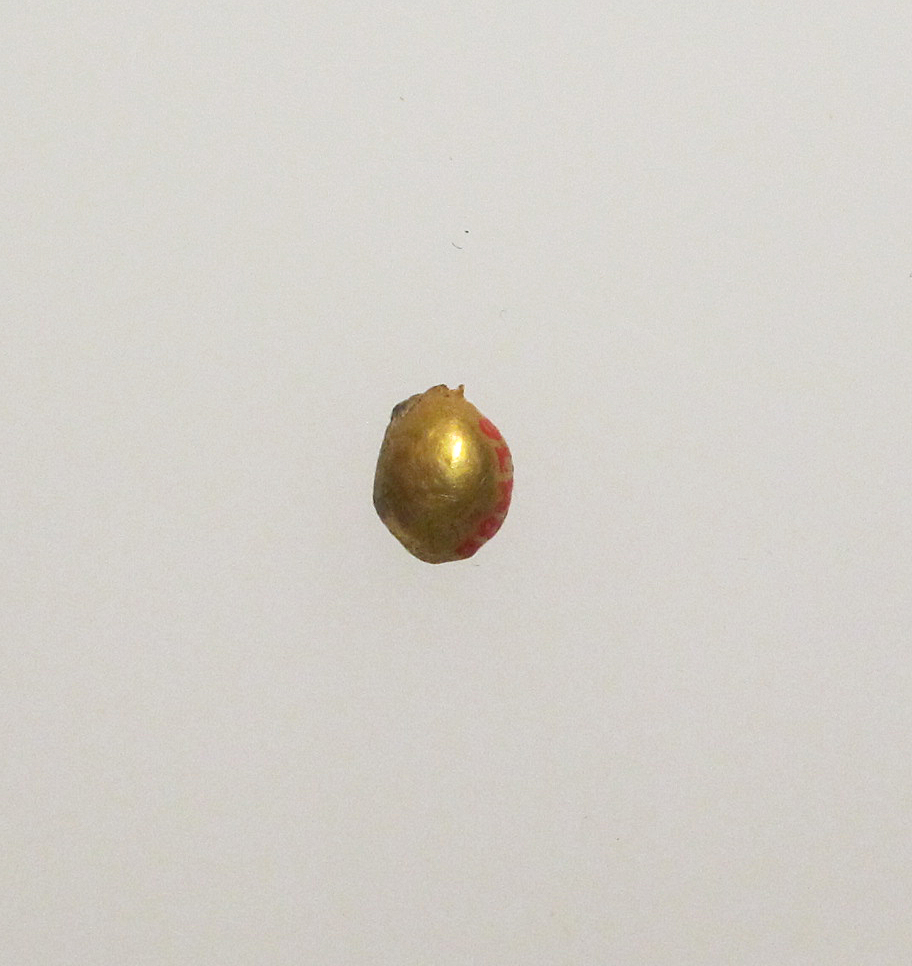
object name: bead ornament, oval shaped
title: Bead ornament, oval-shaped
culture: roman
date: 201-300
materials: gold